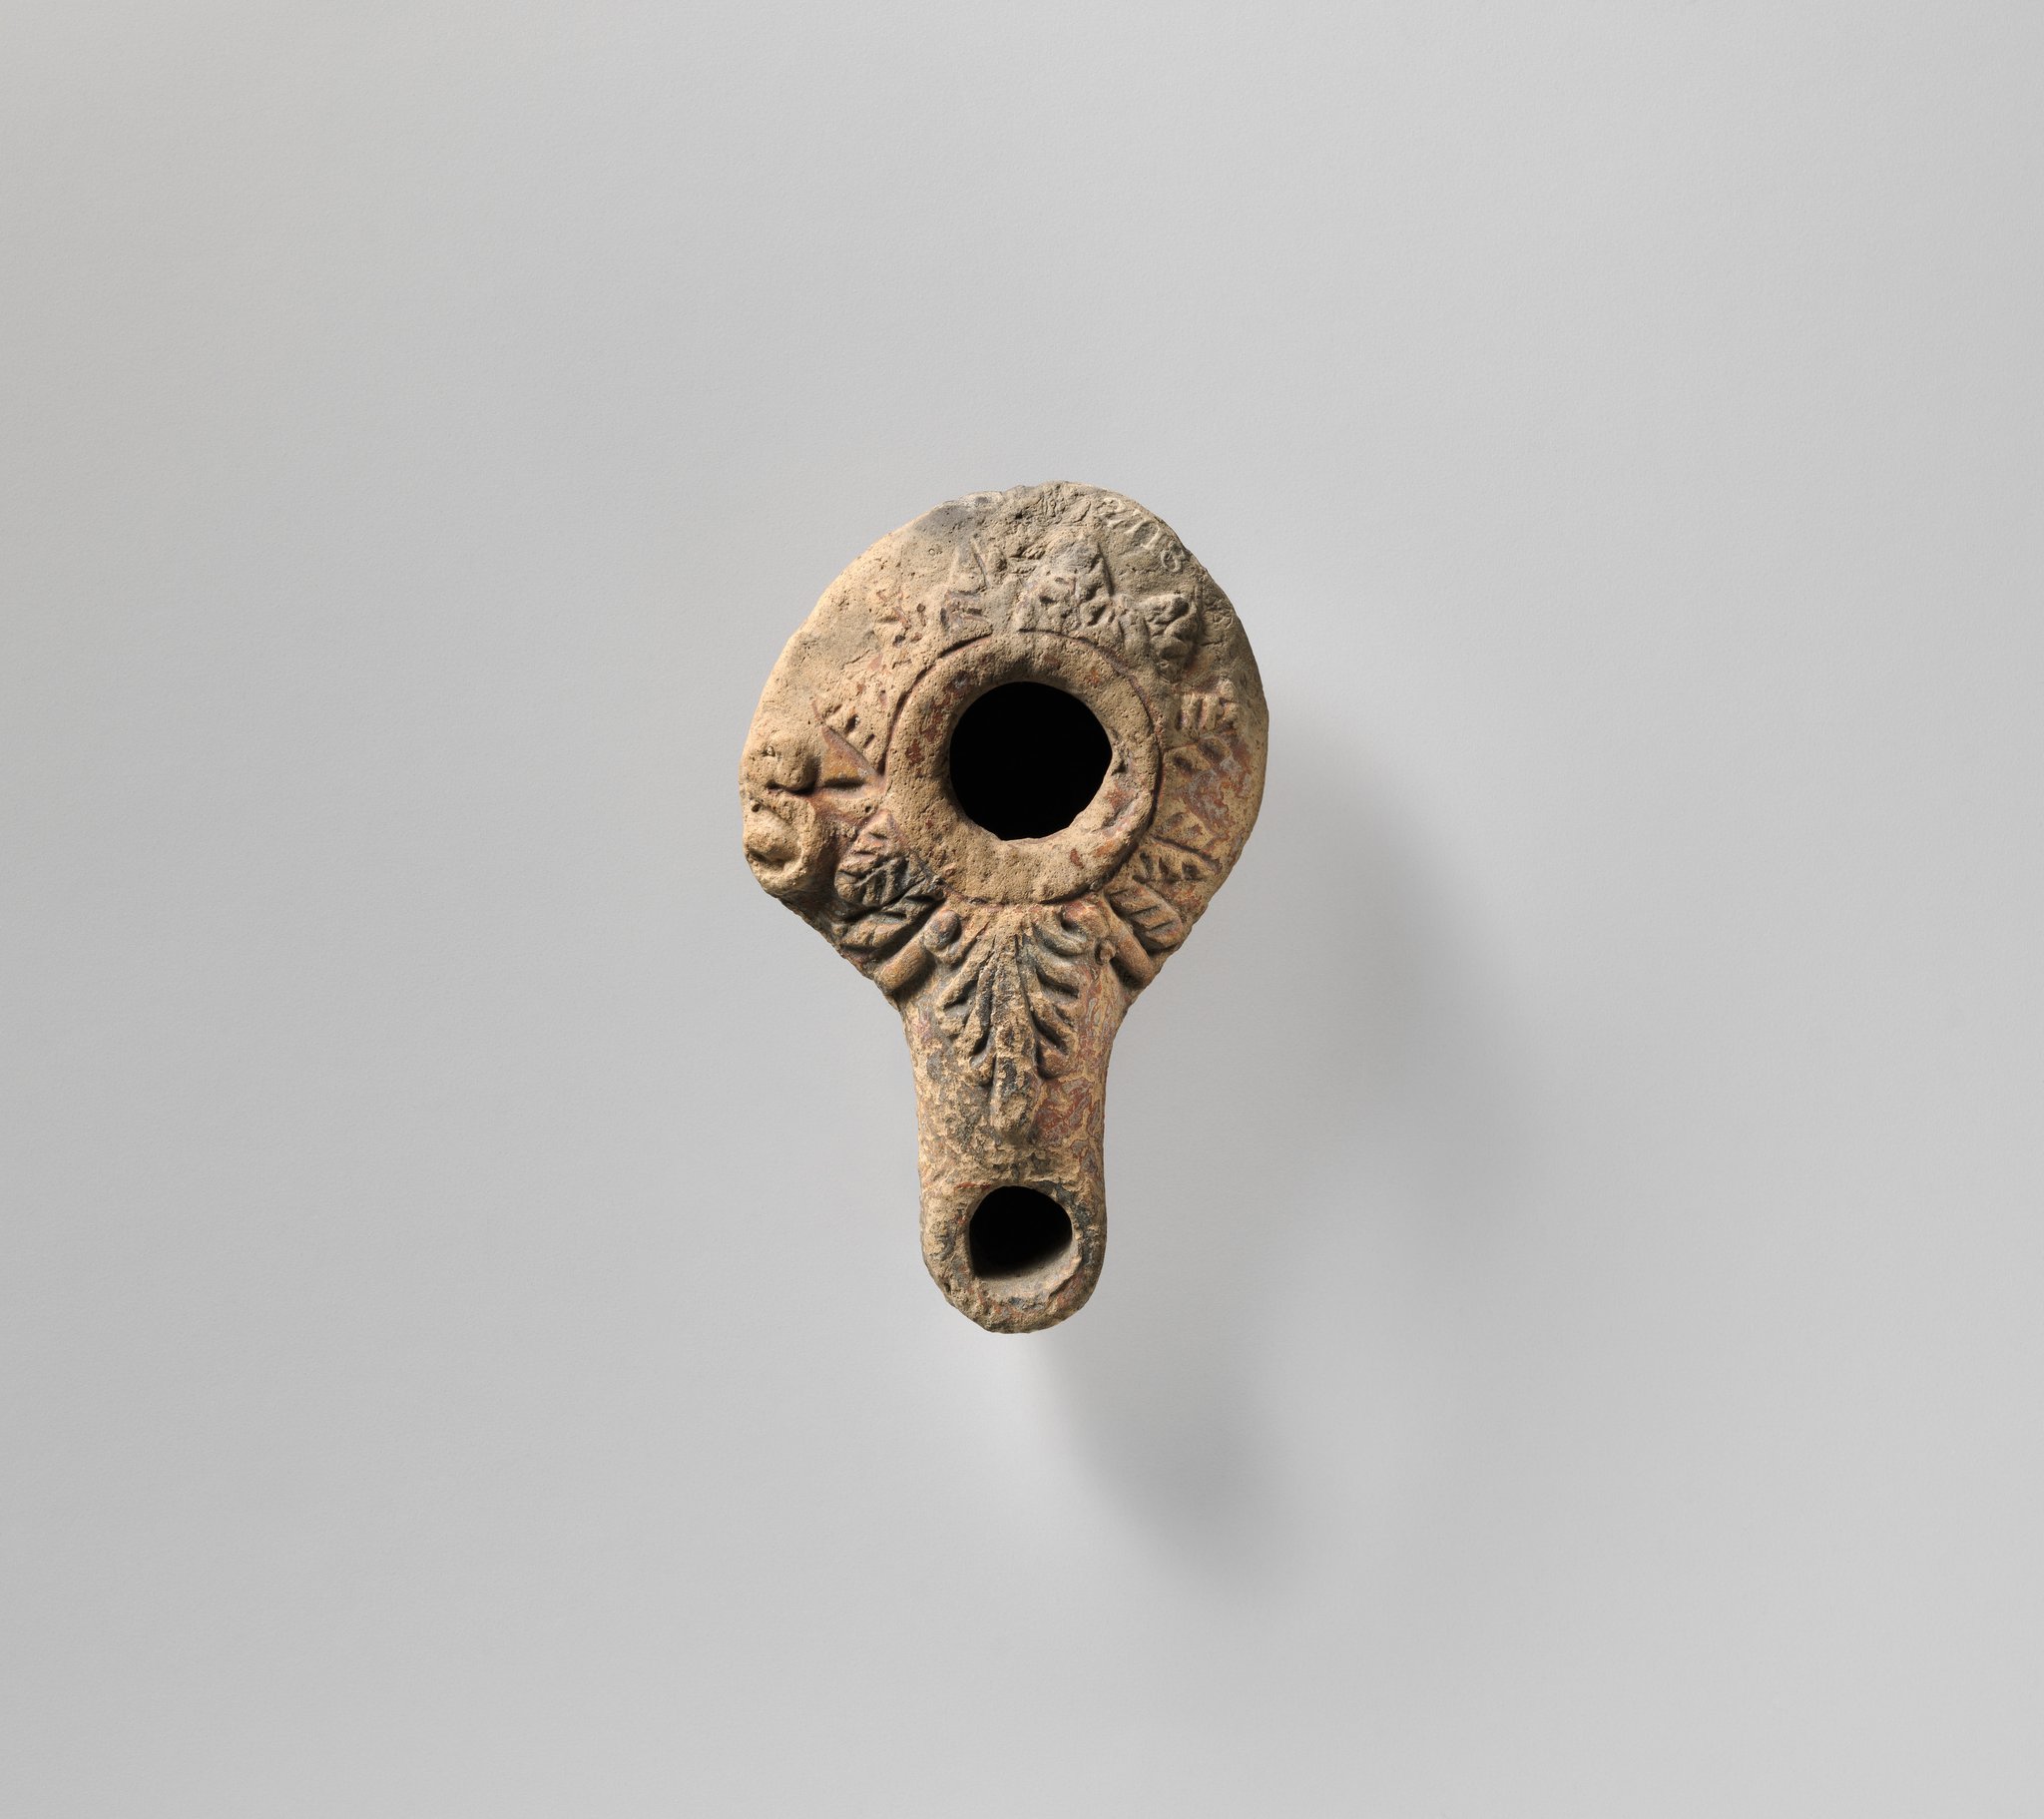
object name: lamp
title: Terracotta oil lamp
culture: greek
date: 7000 BCE-330 CE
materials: terracotta